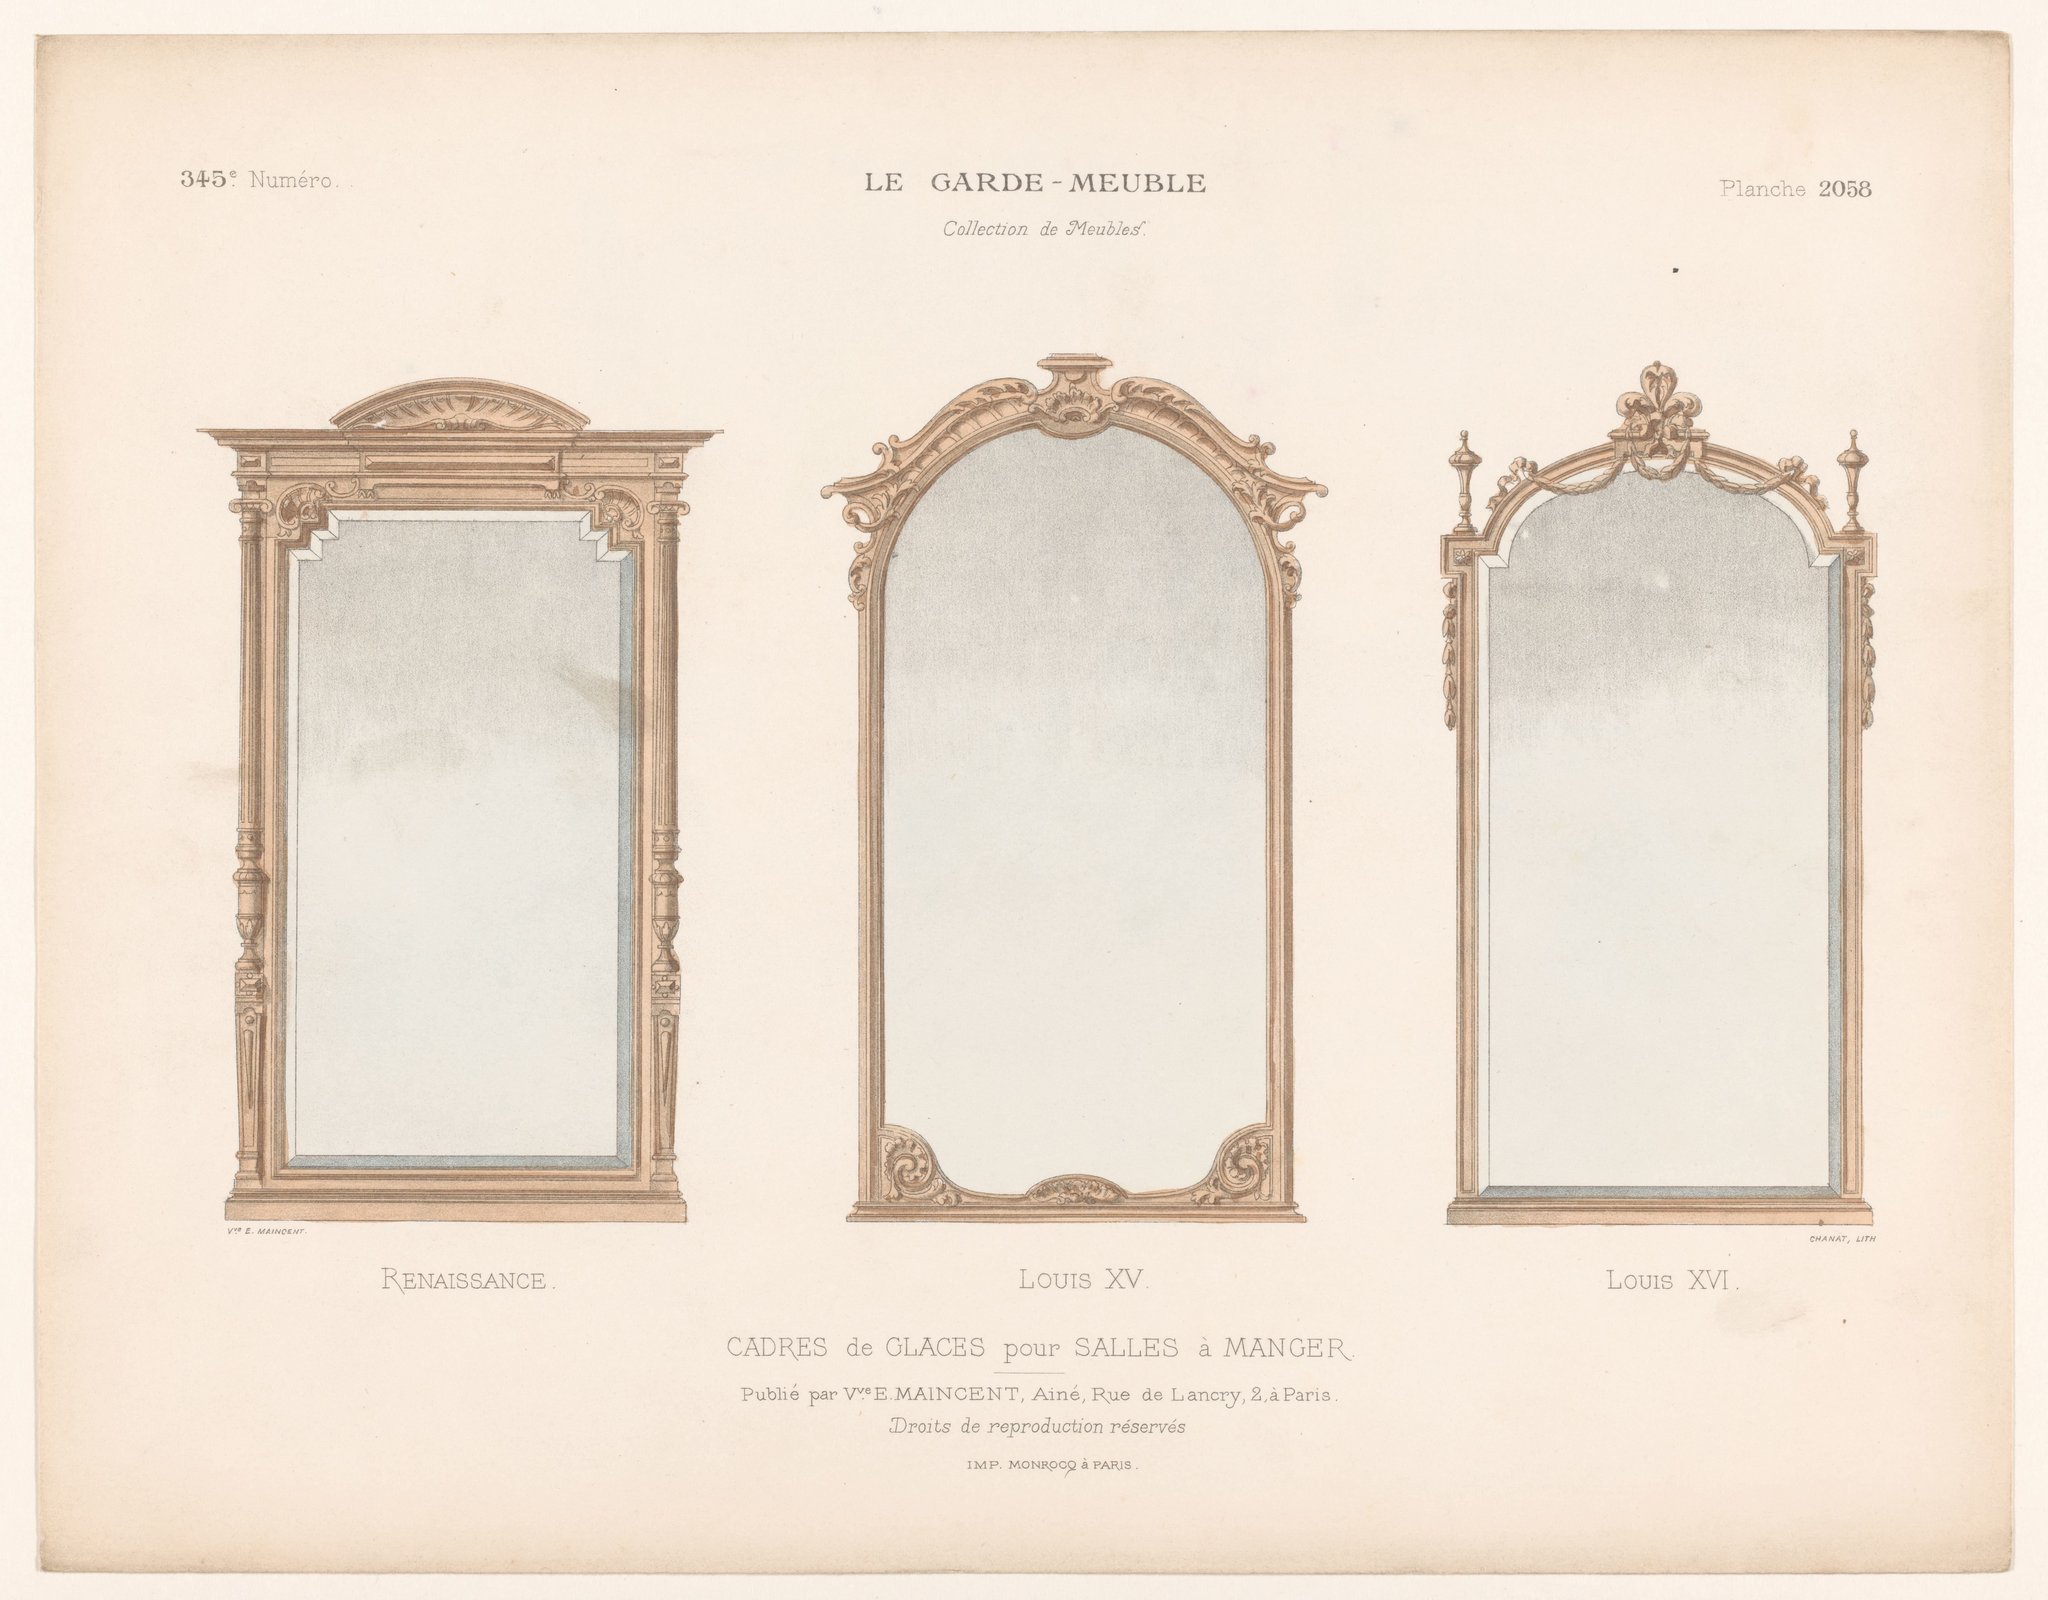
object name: print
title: Cadres de glaces pour salles à manger / Renaissance / Louis XV / Louis XVI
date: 1895-1935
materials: paper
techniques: hand coloring, lithograph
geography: paris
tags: mirror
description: Ieder Livraison in de serie Le Garde-Meuble bevat negen platen: drie 'sièges' (zitmeubels), drie 'meubles' (diverse meubels zoals tafels en kasten) en drie 'tentures' (gordijnen en draperieën).